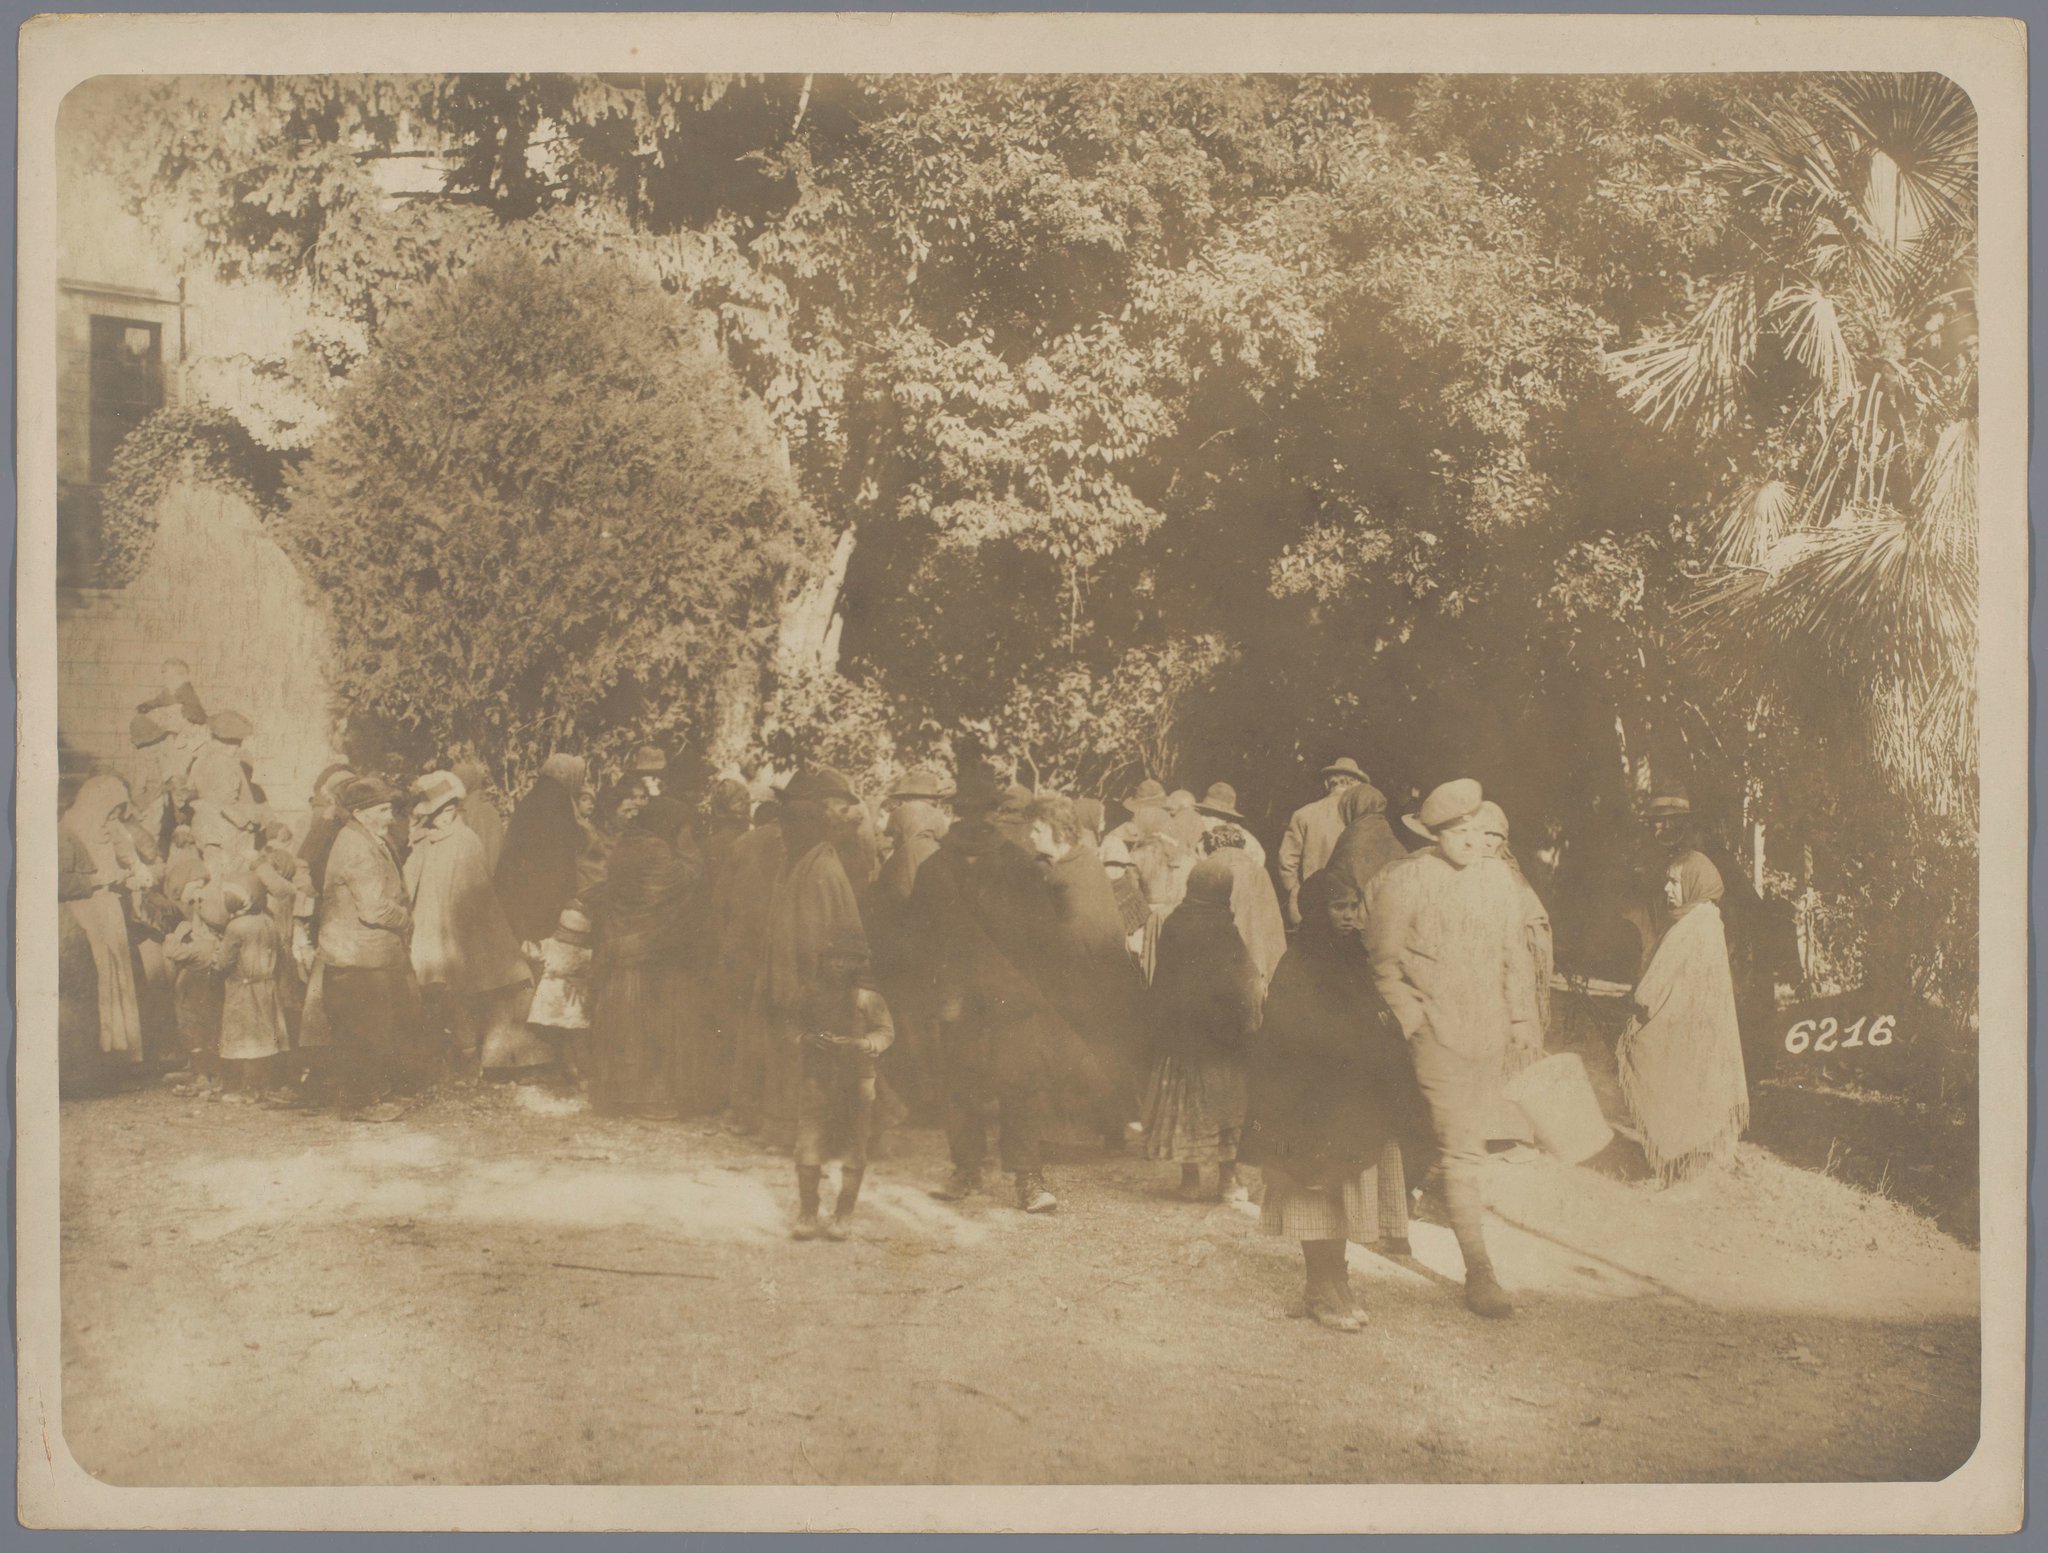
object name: photograph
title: Burgers op een plein met bomen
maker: Anonymous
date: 1914-1918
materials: paper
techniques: gelatin silver print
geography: romania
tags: non-combatants ~ war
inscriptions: number: ‘6216’